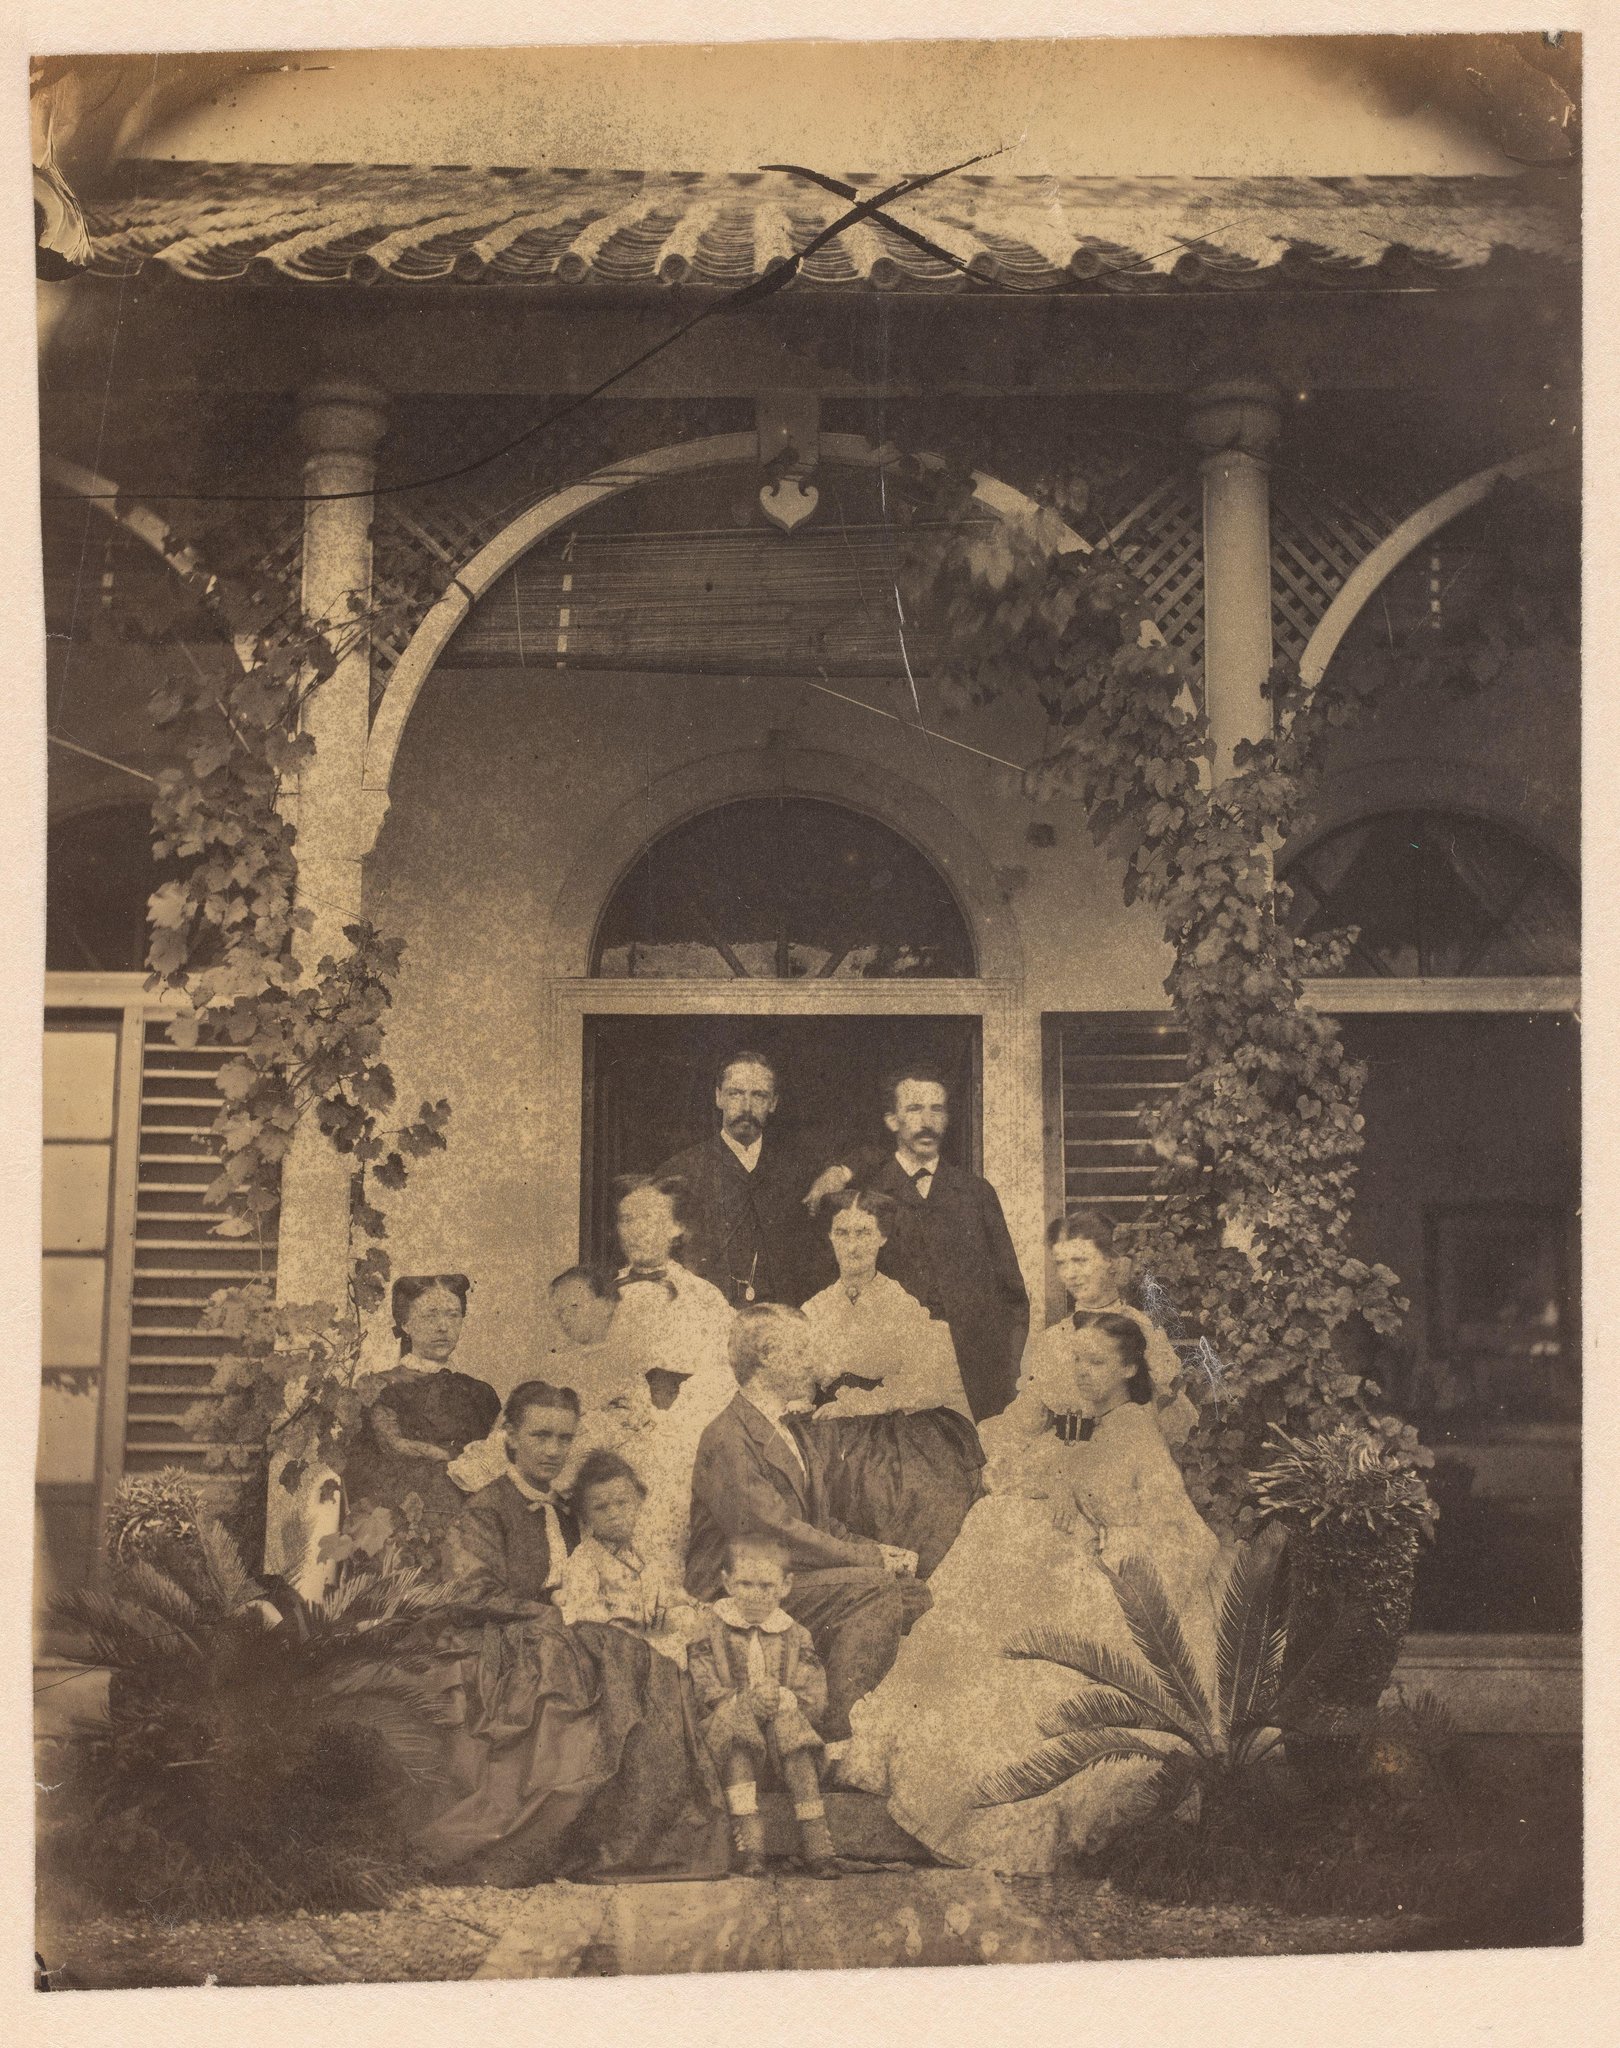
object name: photograph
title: Groepsportret bij het huis van Thomas Glover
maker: antoon bauduin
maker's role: amateurfotograaf, hoogleraar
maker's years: 1820-1885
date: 1862-1866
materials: paper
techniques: albumen print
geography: japan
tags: anonymous historical persons portrayed in a group, in a group-portrait, japan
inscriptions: number: ‘BD 216’, number: ‘36’